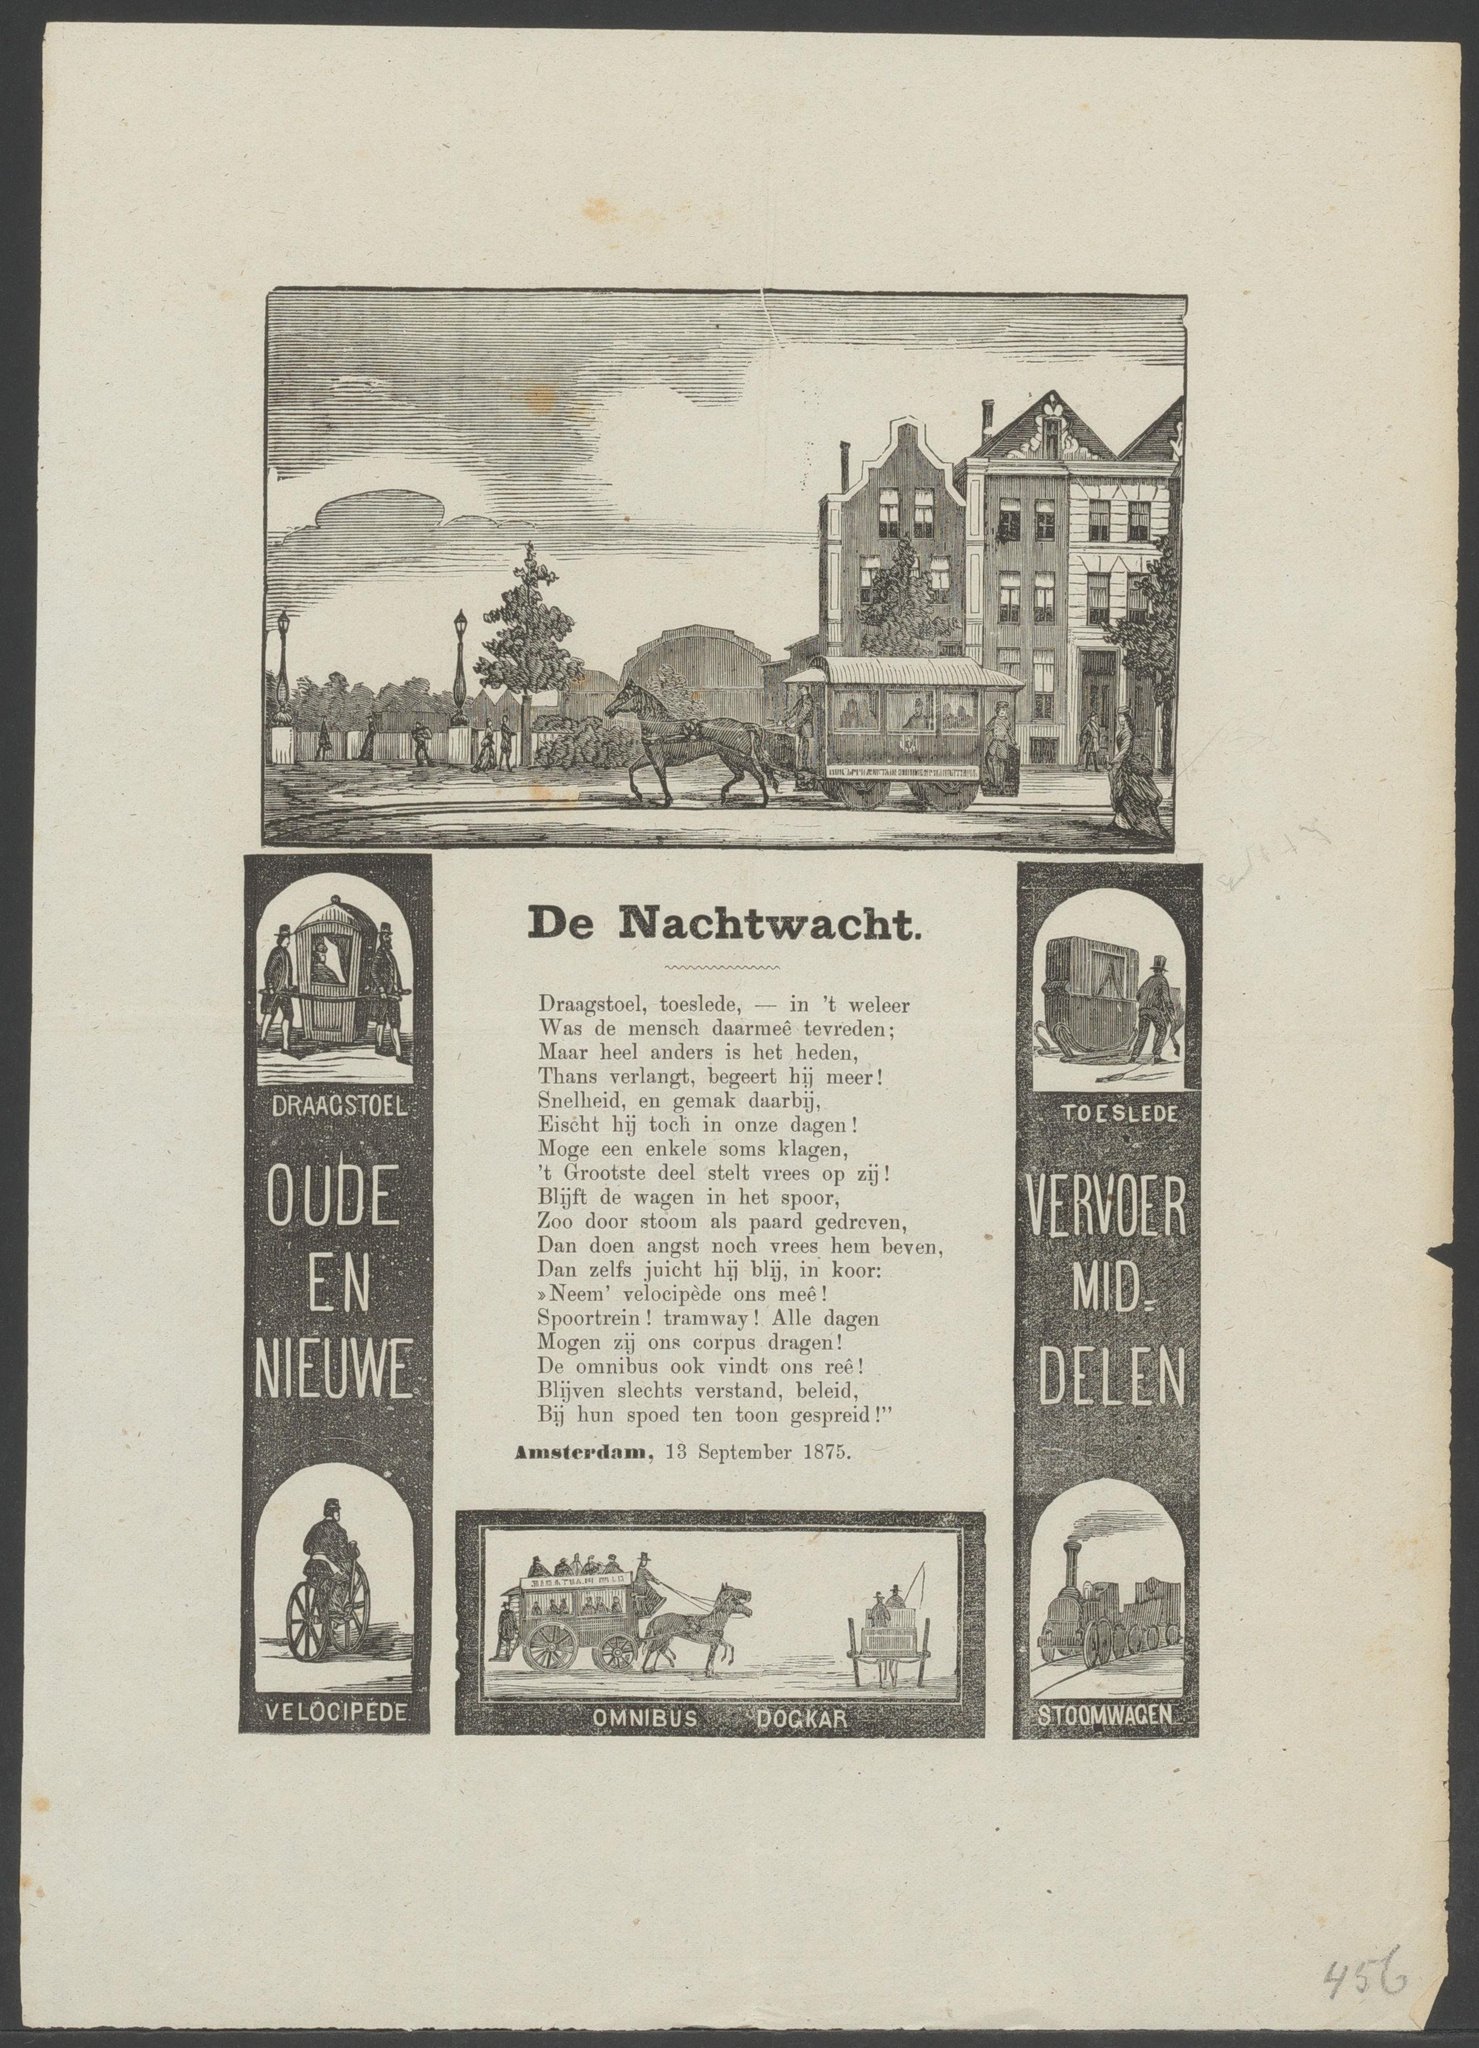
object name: print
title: Kermisprent van de Amsterdamse nachtwacht voor het jaar 1875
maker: Anonymous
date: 1875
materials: paper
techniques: letterpress printing, engraving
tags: night patrol, pleasure fair and circus, amsterdam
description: Kermisprent van de Amsterdamse nachtwacht (ratelwacht), 13 september 1875. Centraal een gedicht over de draagslee en toeslede. Onderwerpsrubrieken binnen de Atlas Zeden en Gewoonten: Zeden en gewoonten in engeren zin, Volksleven, Volksbladen, Nieuwjaars- en Kerstwenschen, Amsterdam.